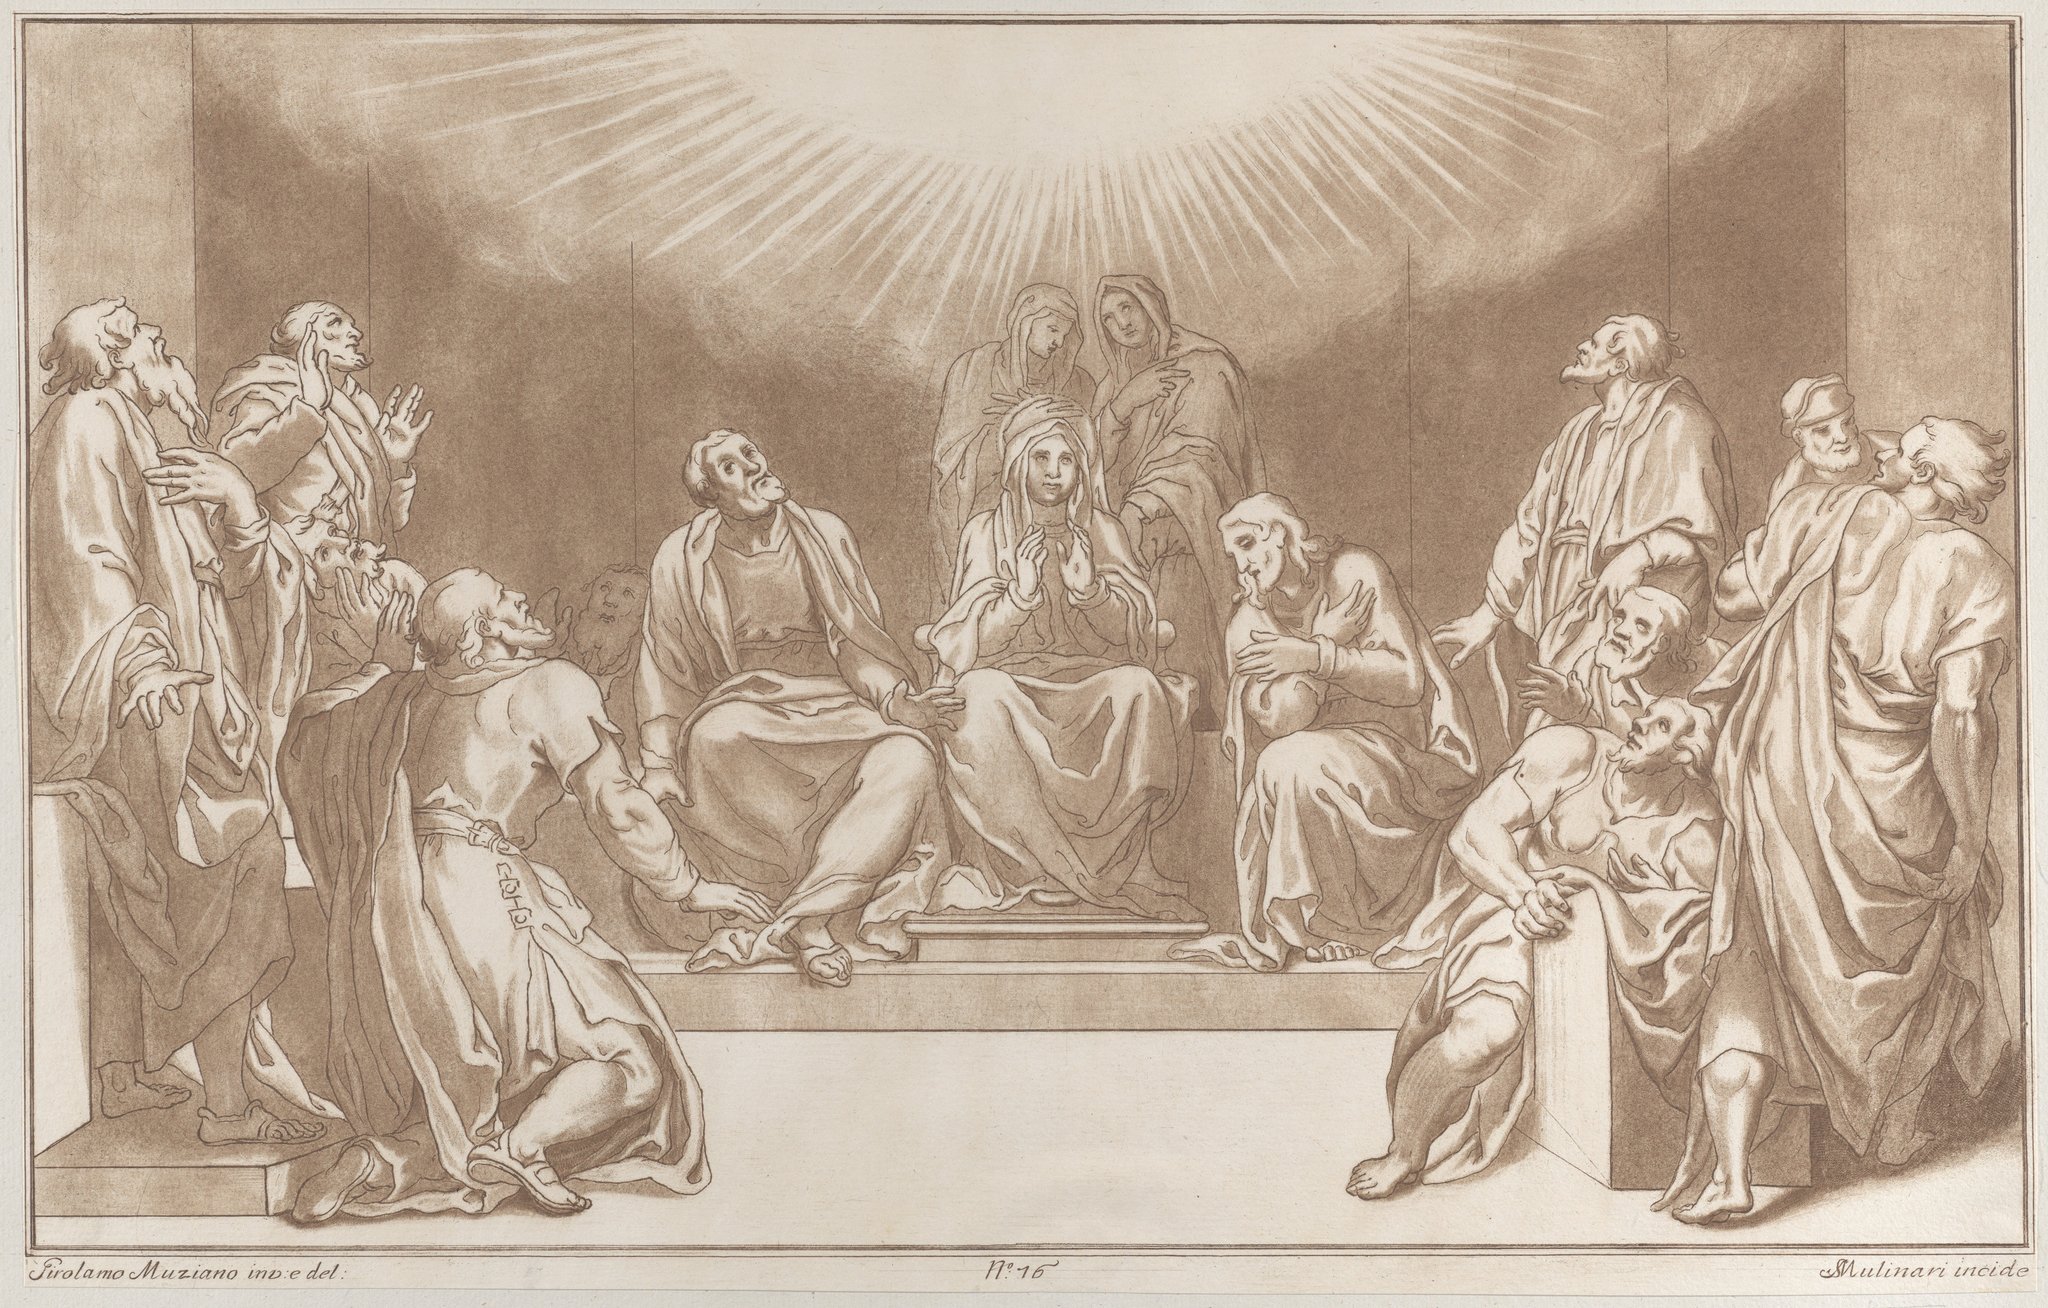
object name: print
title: Descent of the Holy Ghost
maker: stefano mulinari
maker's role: artist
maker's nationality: italian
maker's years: 1736-1795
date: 1760-1790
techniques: aquatint, etching